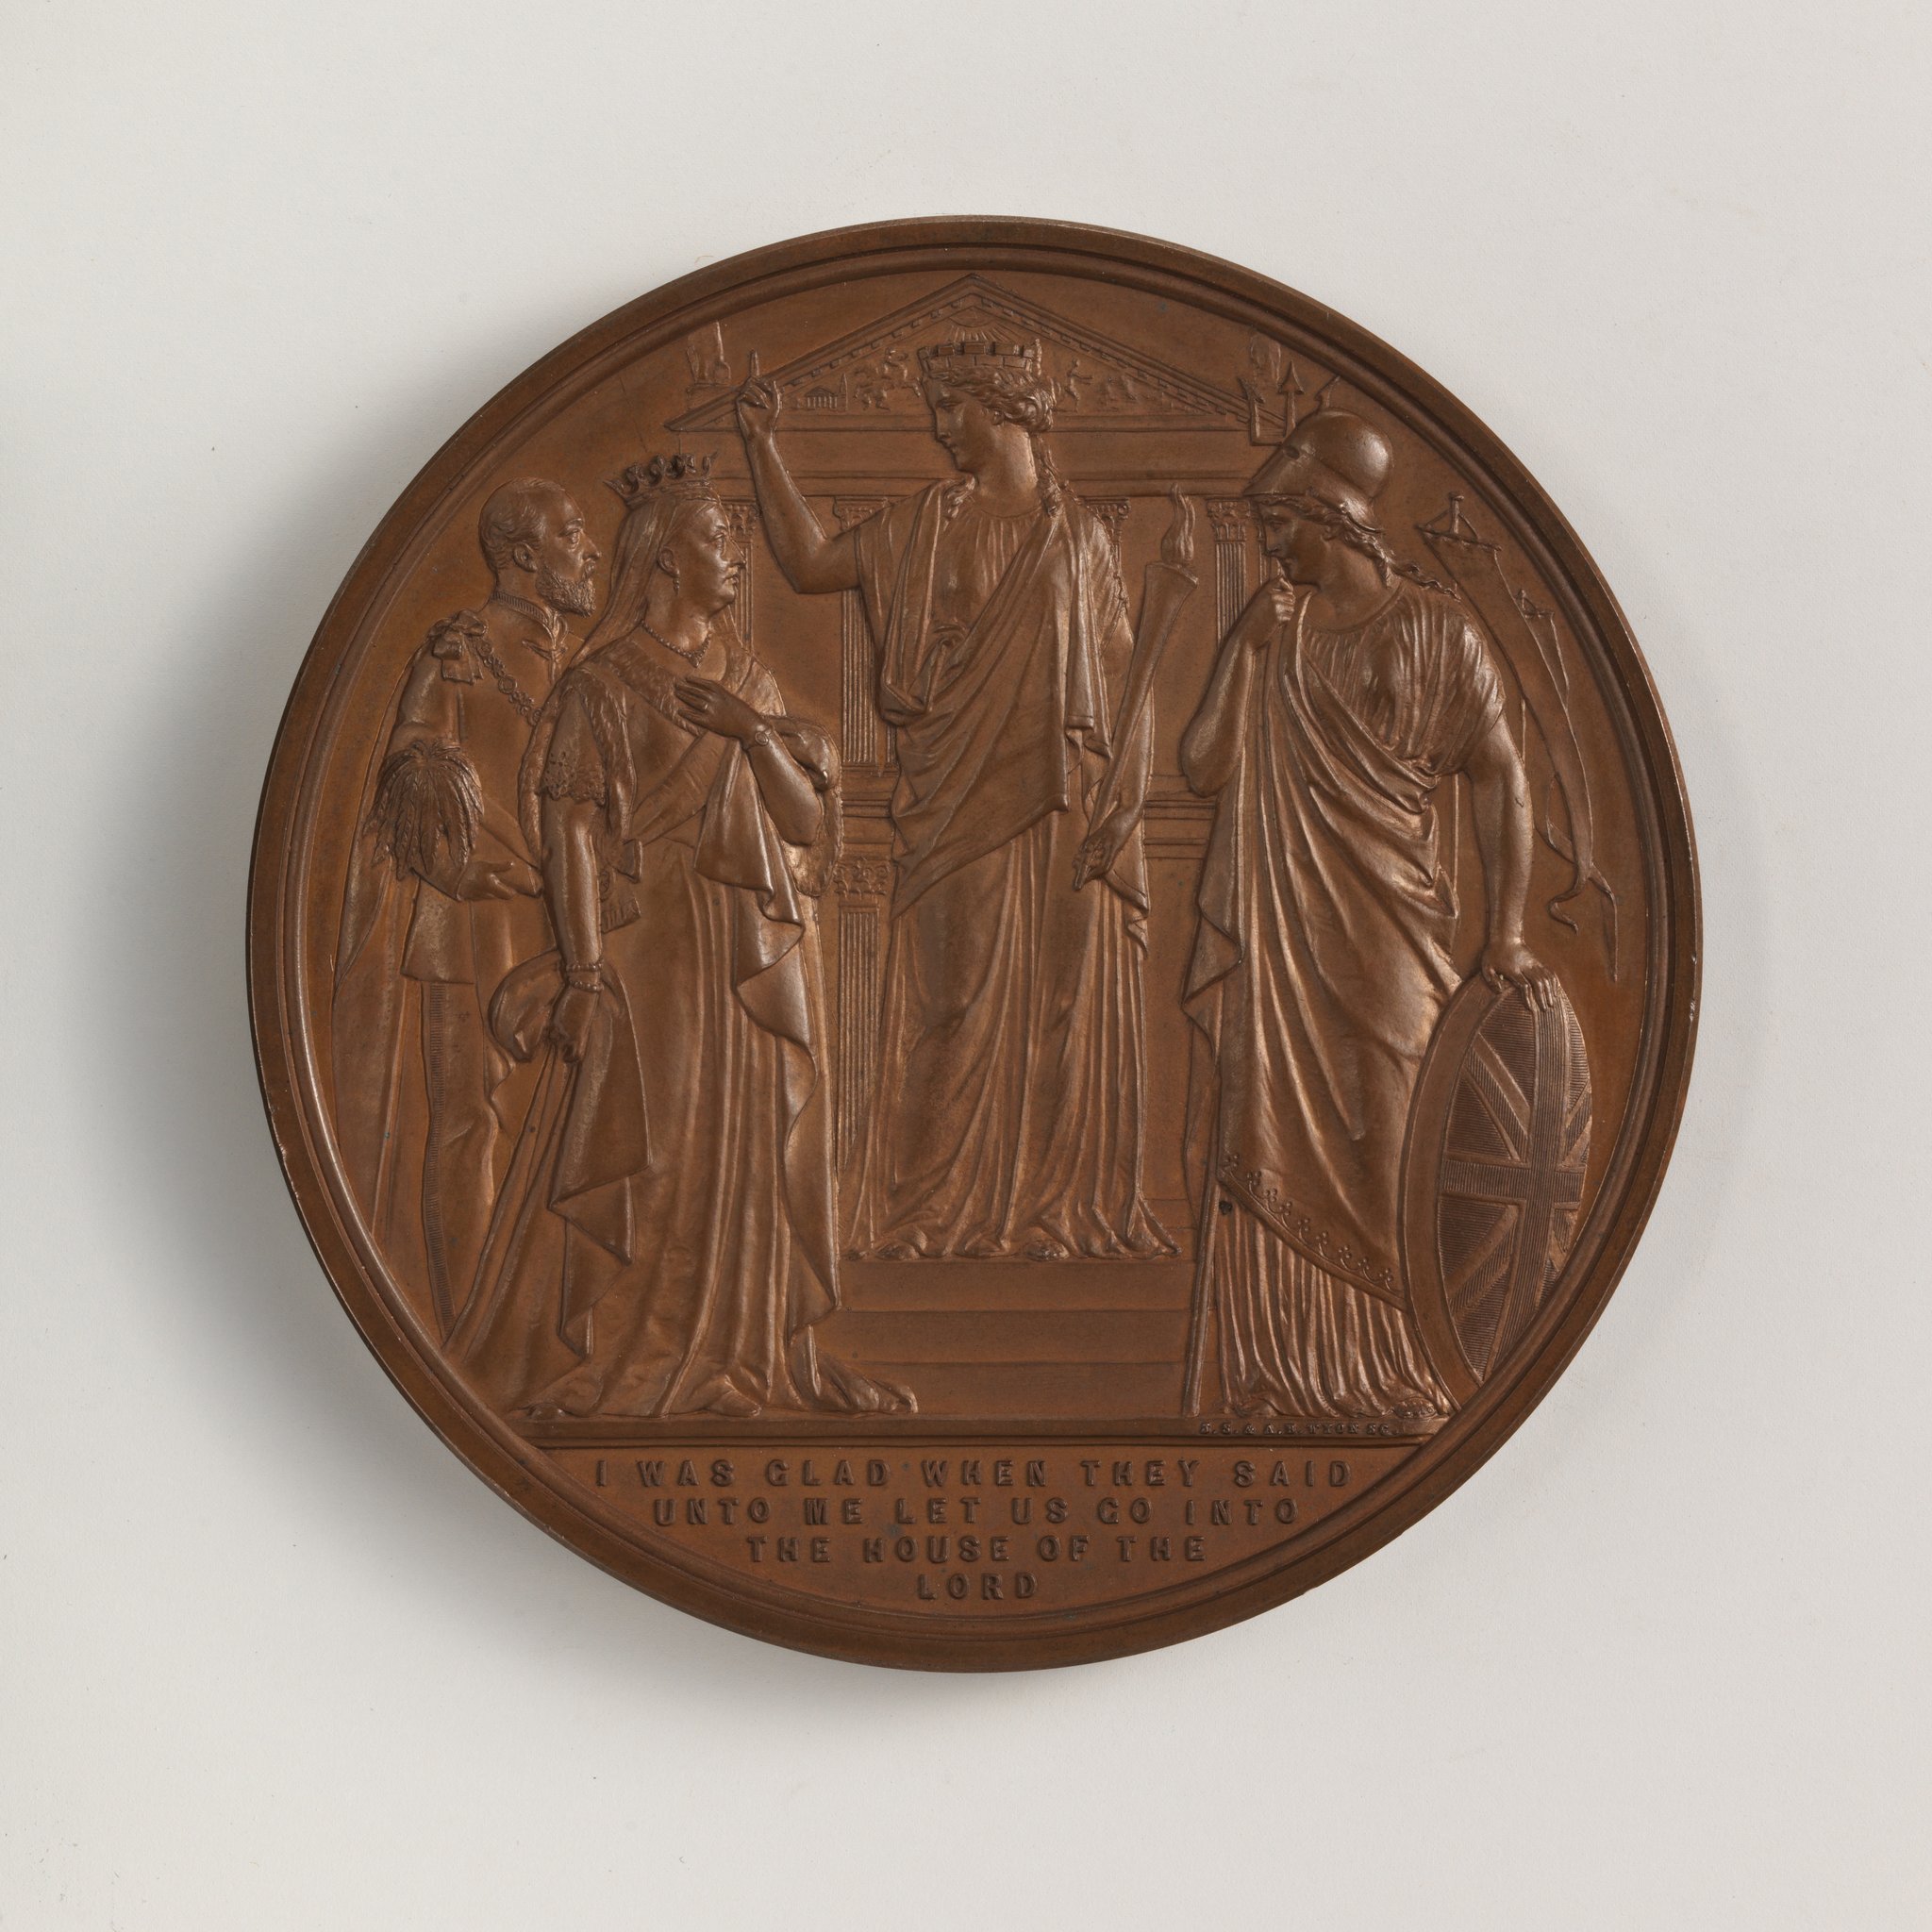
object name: medal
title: Service of Thanksgiving for Recovery of Prince of Wales medal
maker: joseph shepherd wyon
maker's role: artist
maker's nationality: british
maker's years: 1836-1873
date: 1872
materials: bronze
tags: men,women,crowd